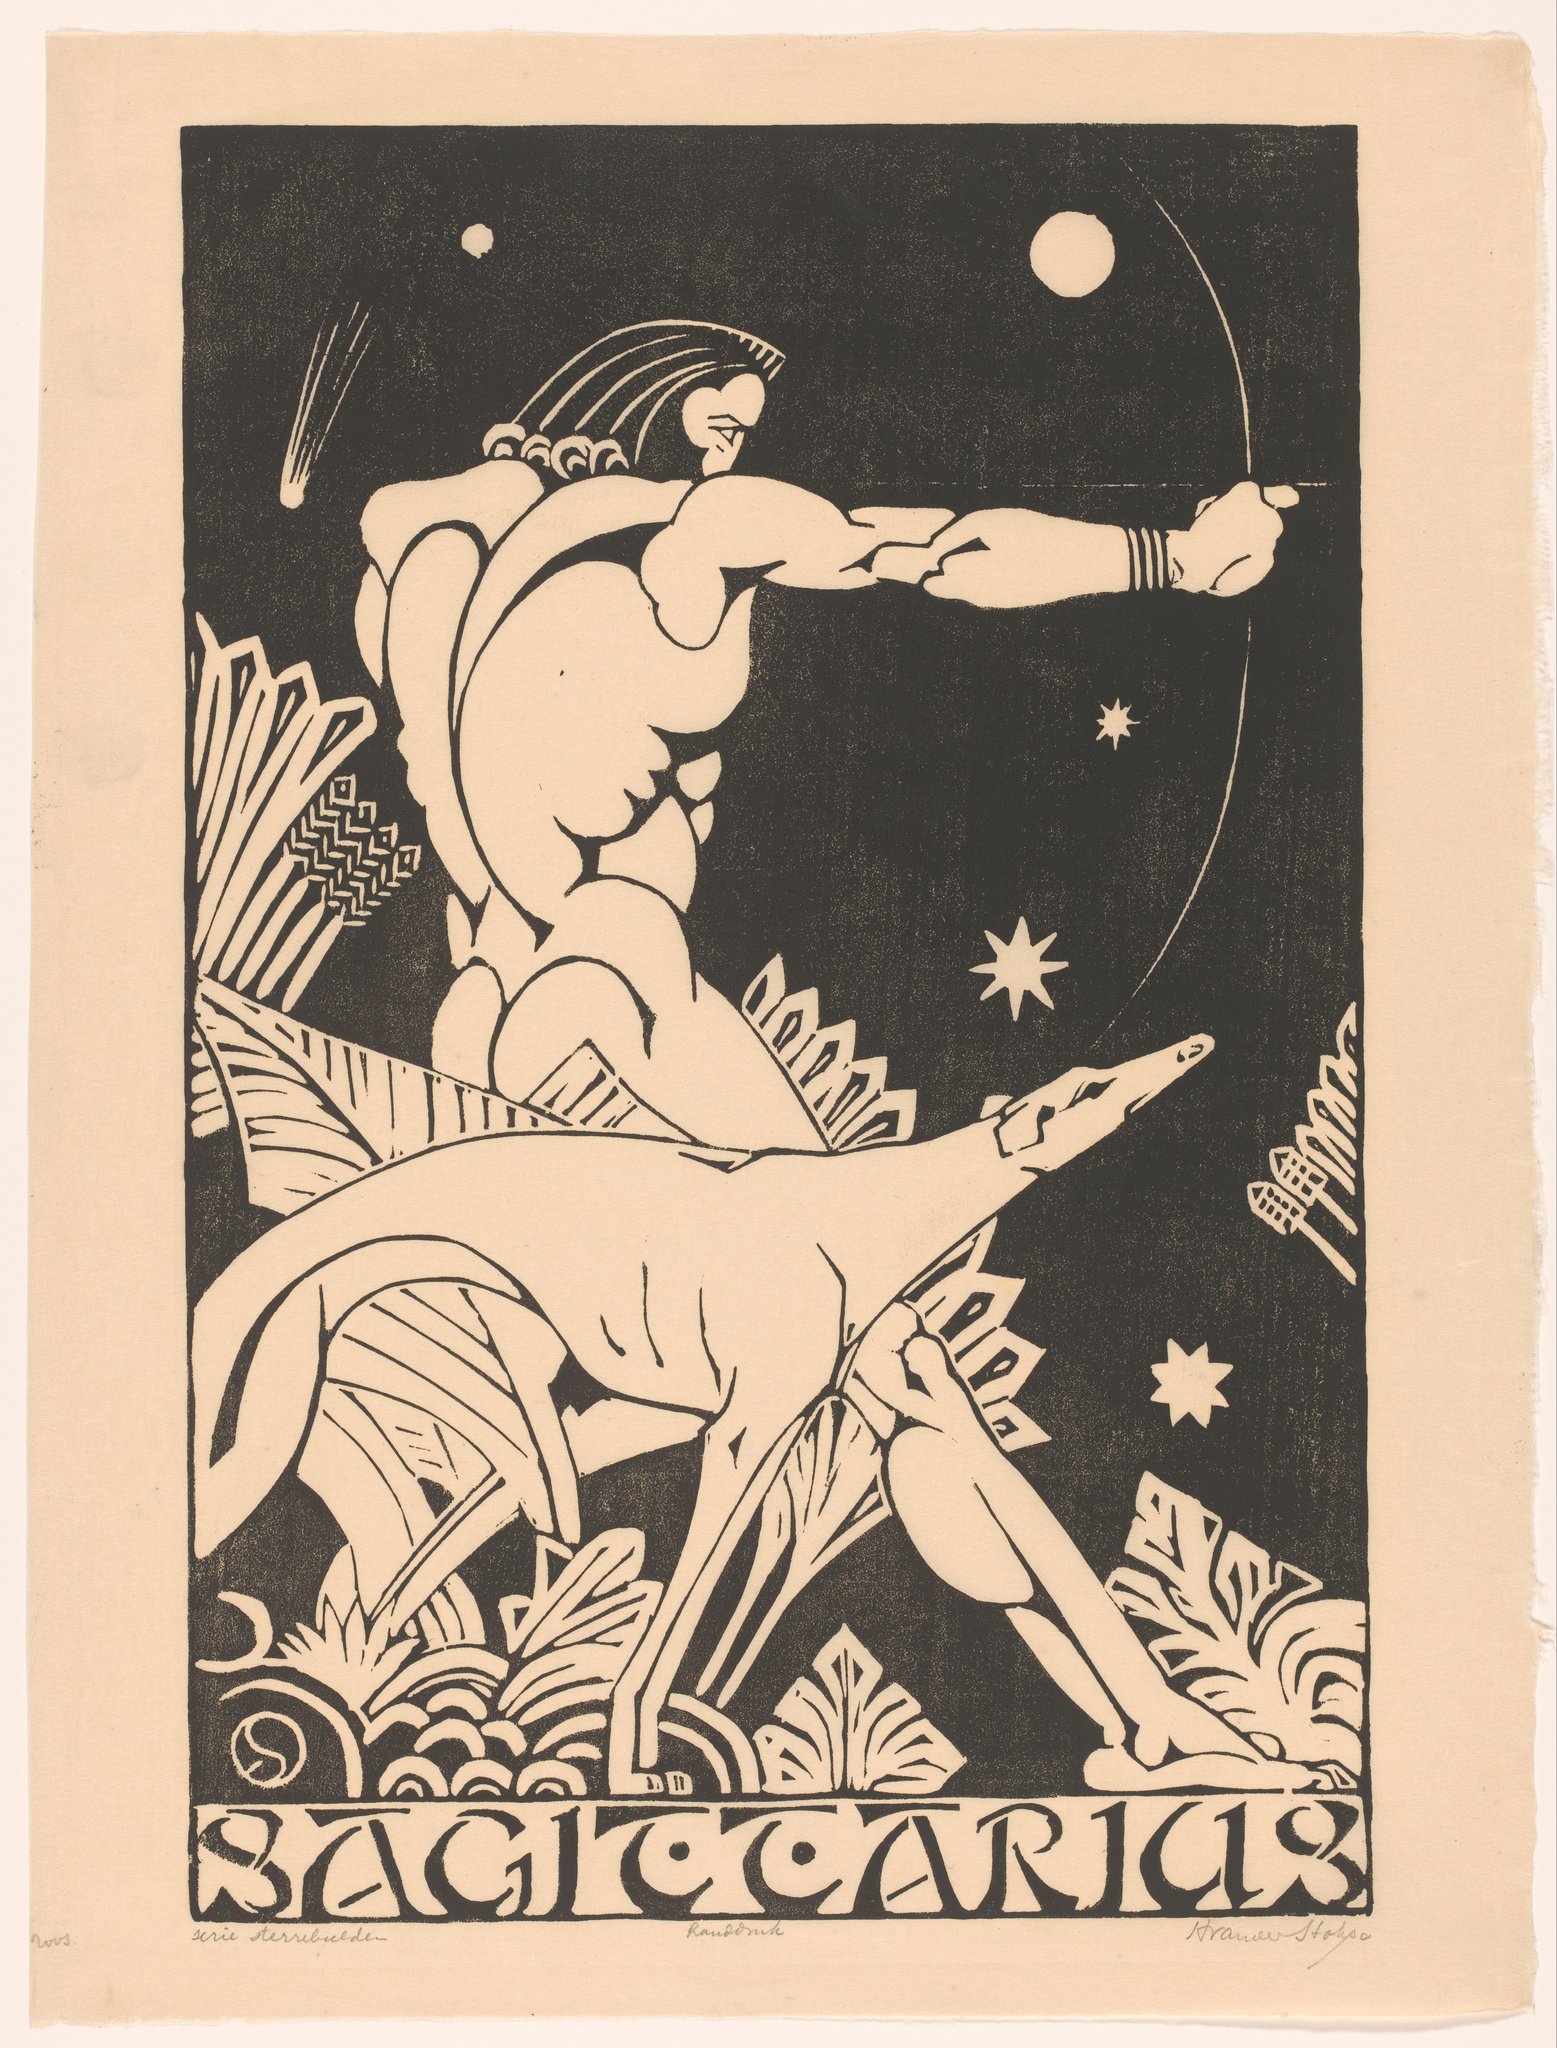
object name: print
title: Sterrenbeeld boogschutter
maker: henri van der stok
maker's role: print maker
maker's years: 1870-1946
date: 1880-1920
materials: paper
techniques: woodcut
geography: netherlands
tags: sagittarius (zodiacal sign of november)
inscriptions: collector's mark: Lugt 2233, inscription: ‘serie sterrebeelden’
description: Een naakte boogschutter met een jachthond voor de sterrenhemel.